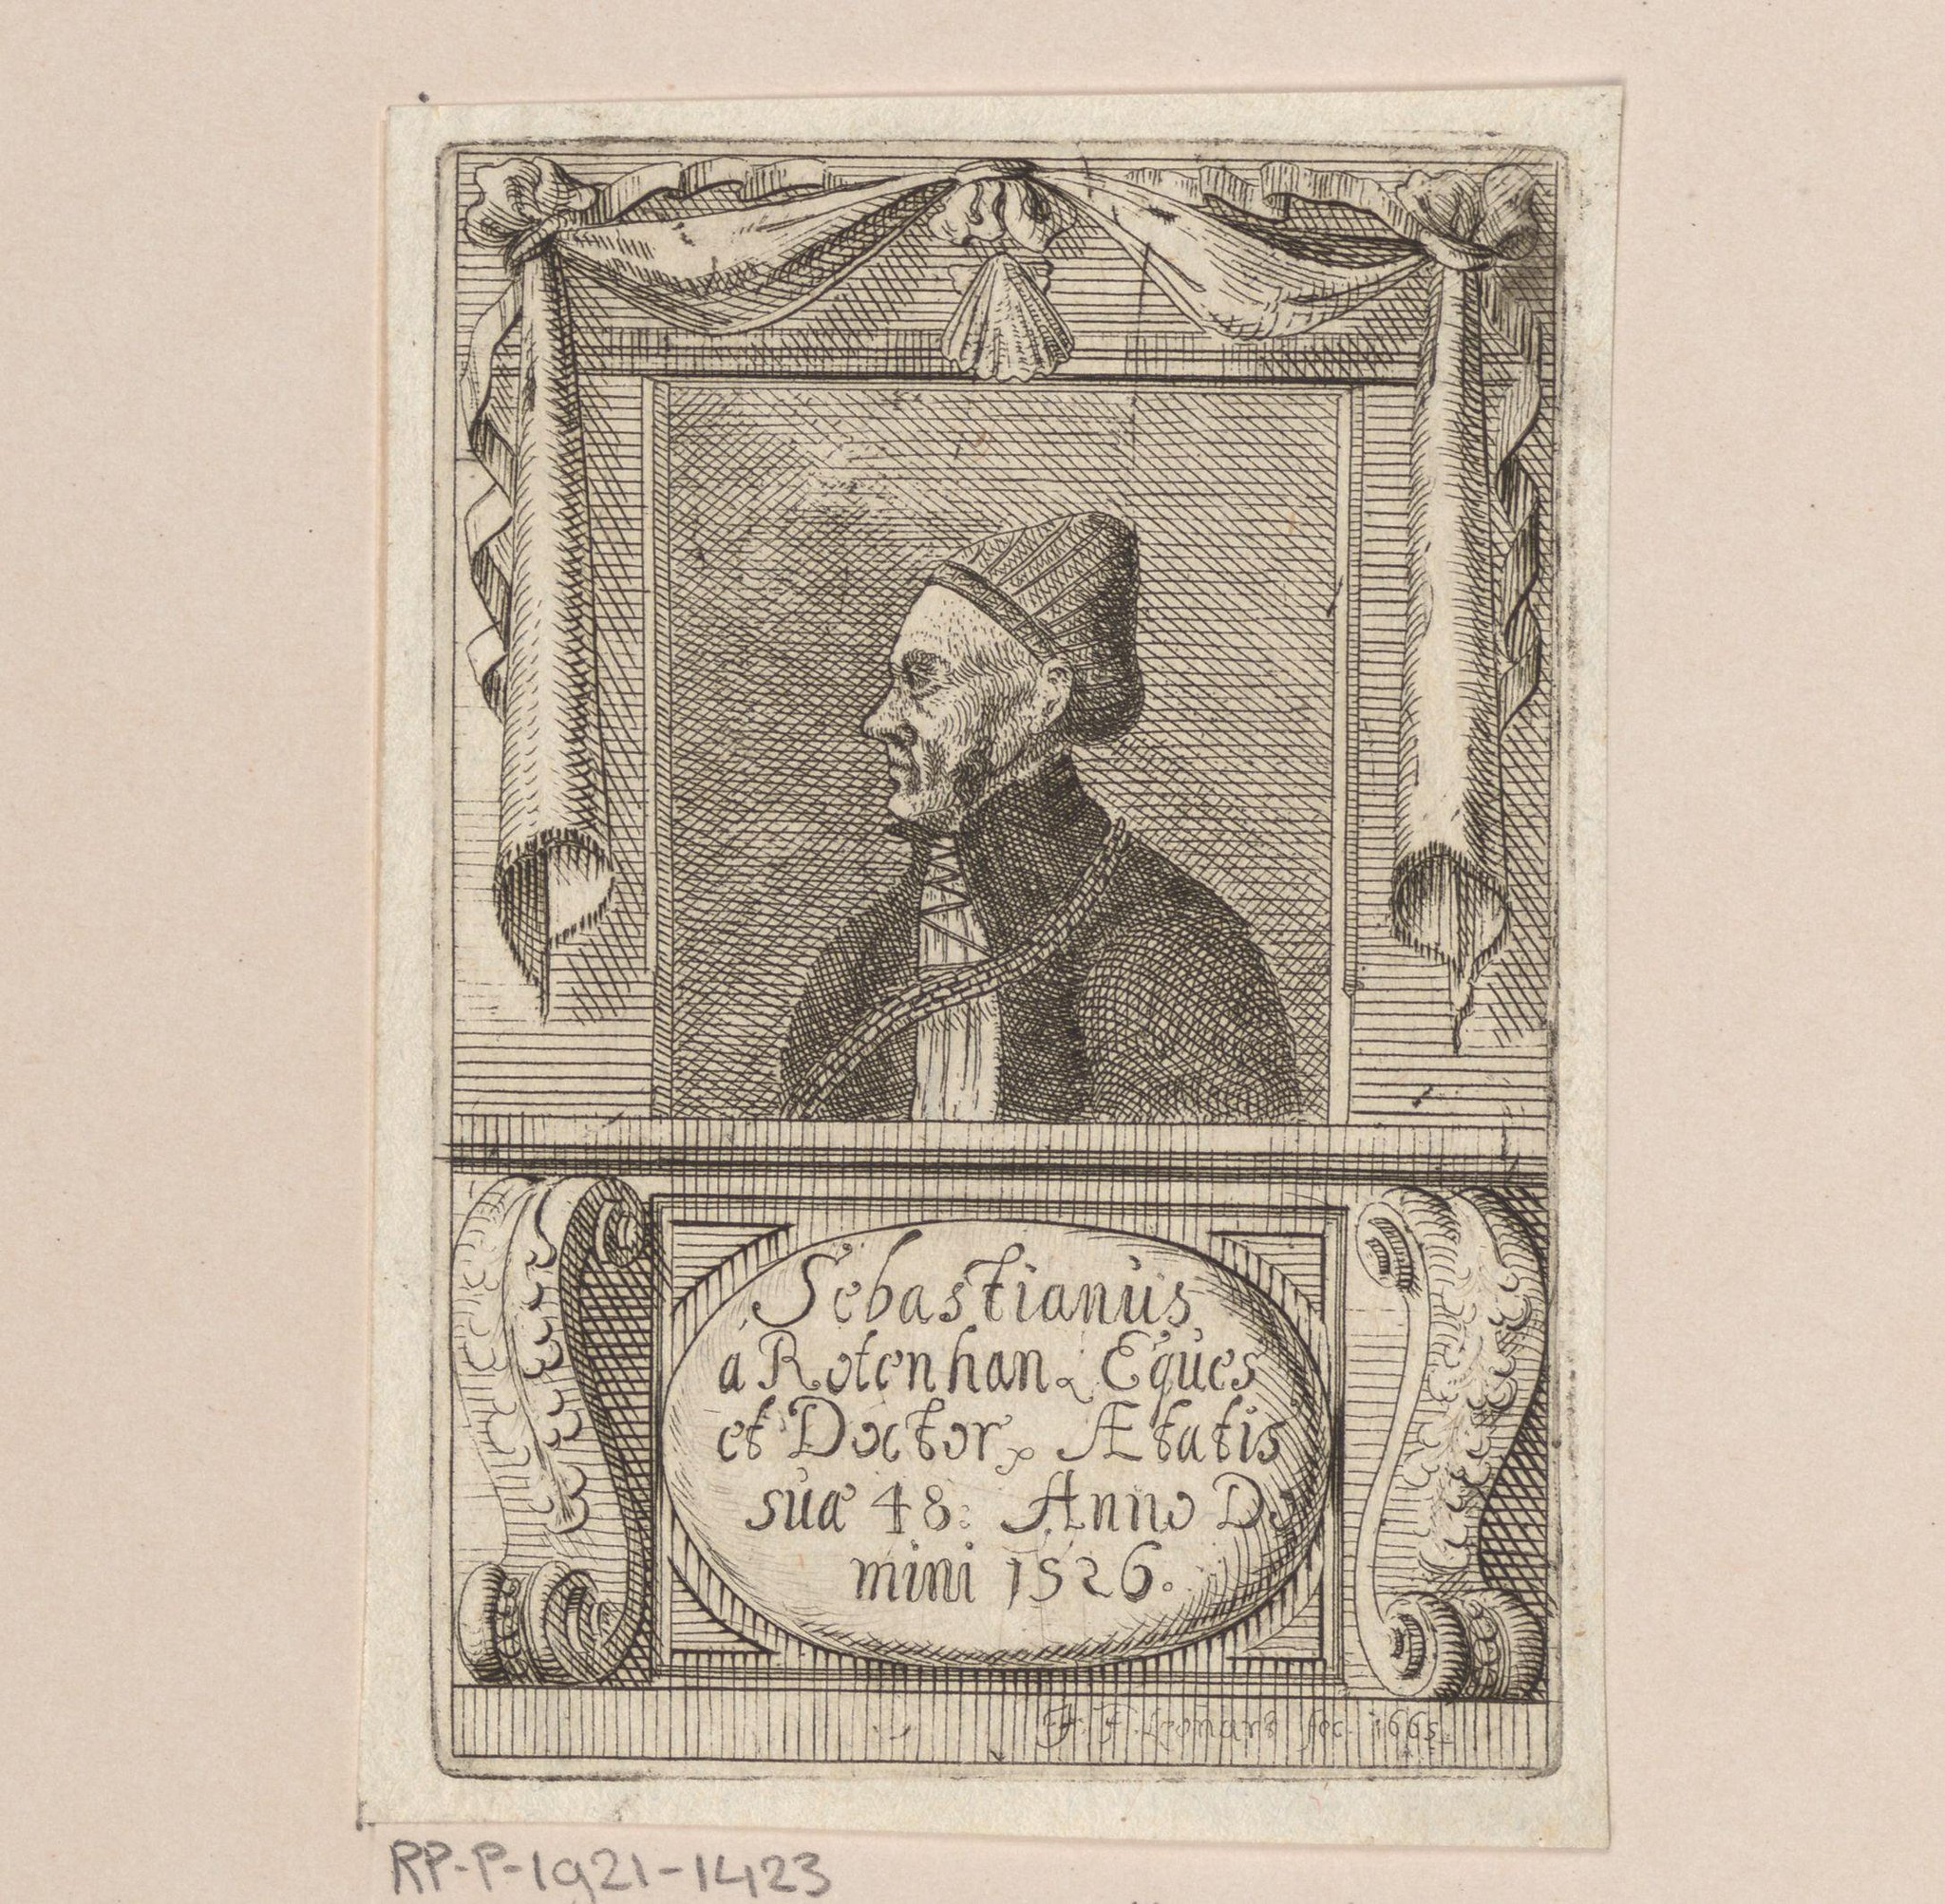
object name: print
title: Portret van Sebastian Rotenhan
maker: johann friedrich leonard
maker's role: print maker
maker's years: 1633-1680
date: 1665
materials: paper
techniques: etching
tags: historical persons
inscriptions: collector's mark: Lugt 2233